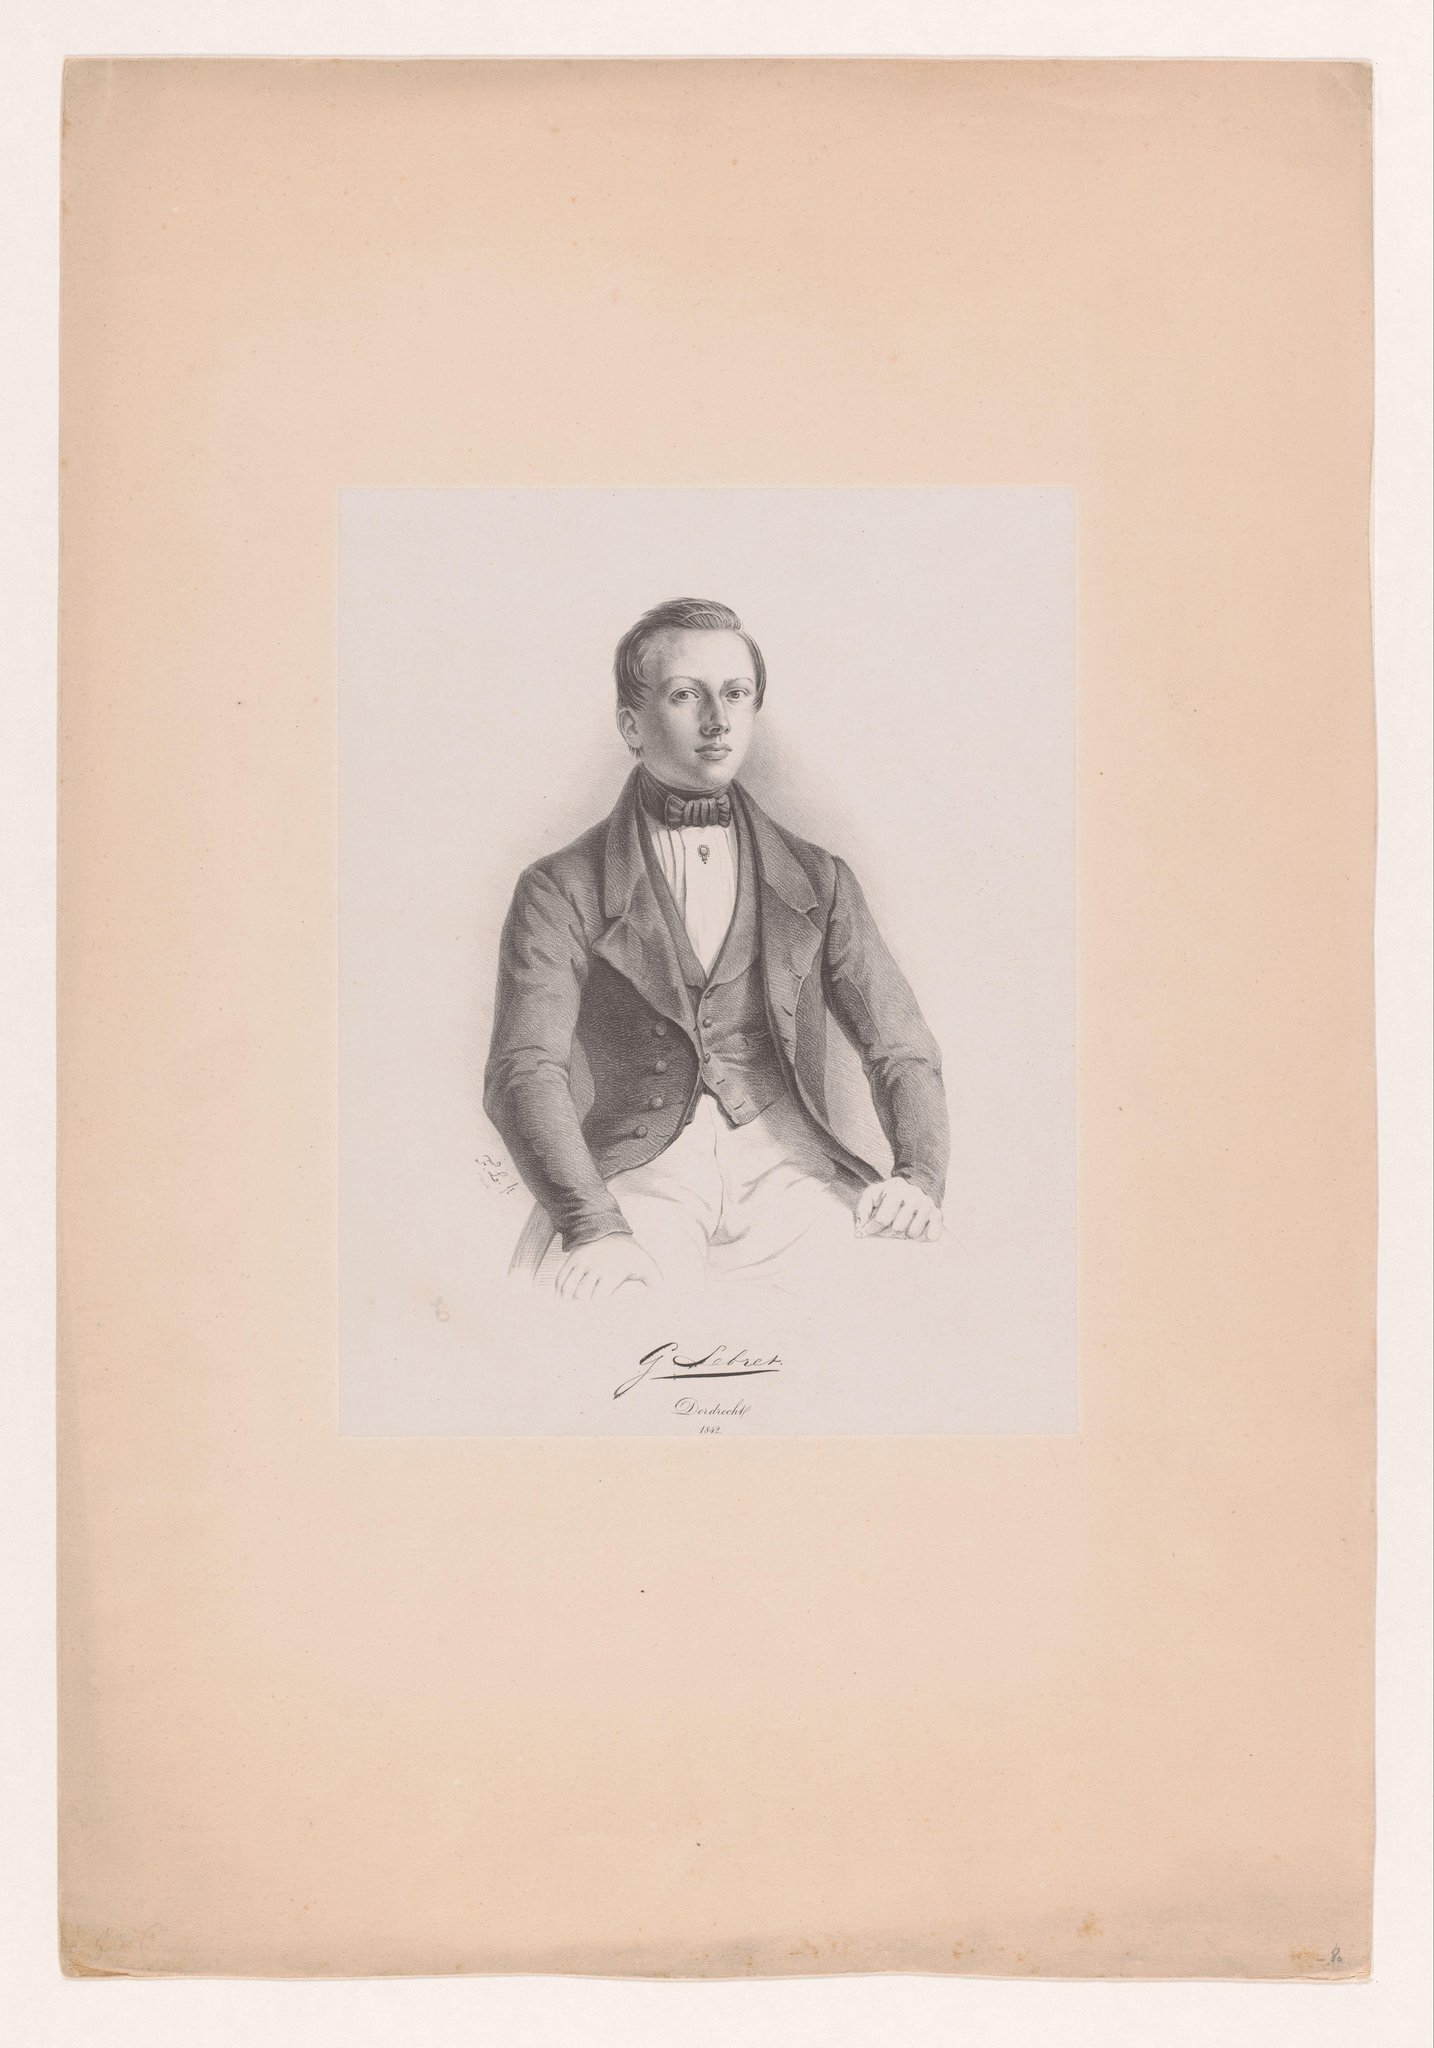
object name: print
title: Portret van Gerrit Lebret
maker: frans lebret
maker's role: draughtsman, painter, print maker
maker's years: 1820-1909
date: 1842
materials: paper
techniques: lithograph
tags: historical persons (+ half-length portrait)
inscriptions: collector's mark: Lugt 2228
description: Onder het portret de signatuur van de geportretteerde.